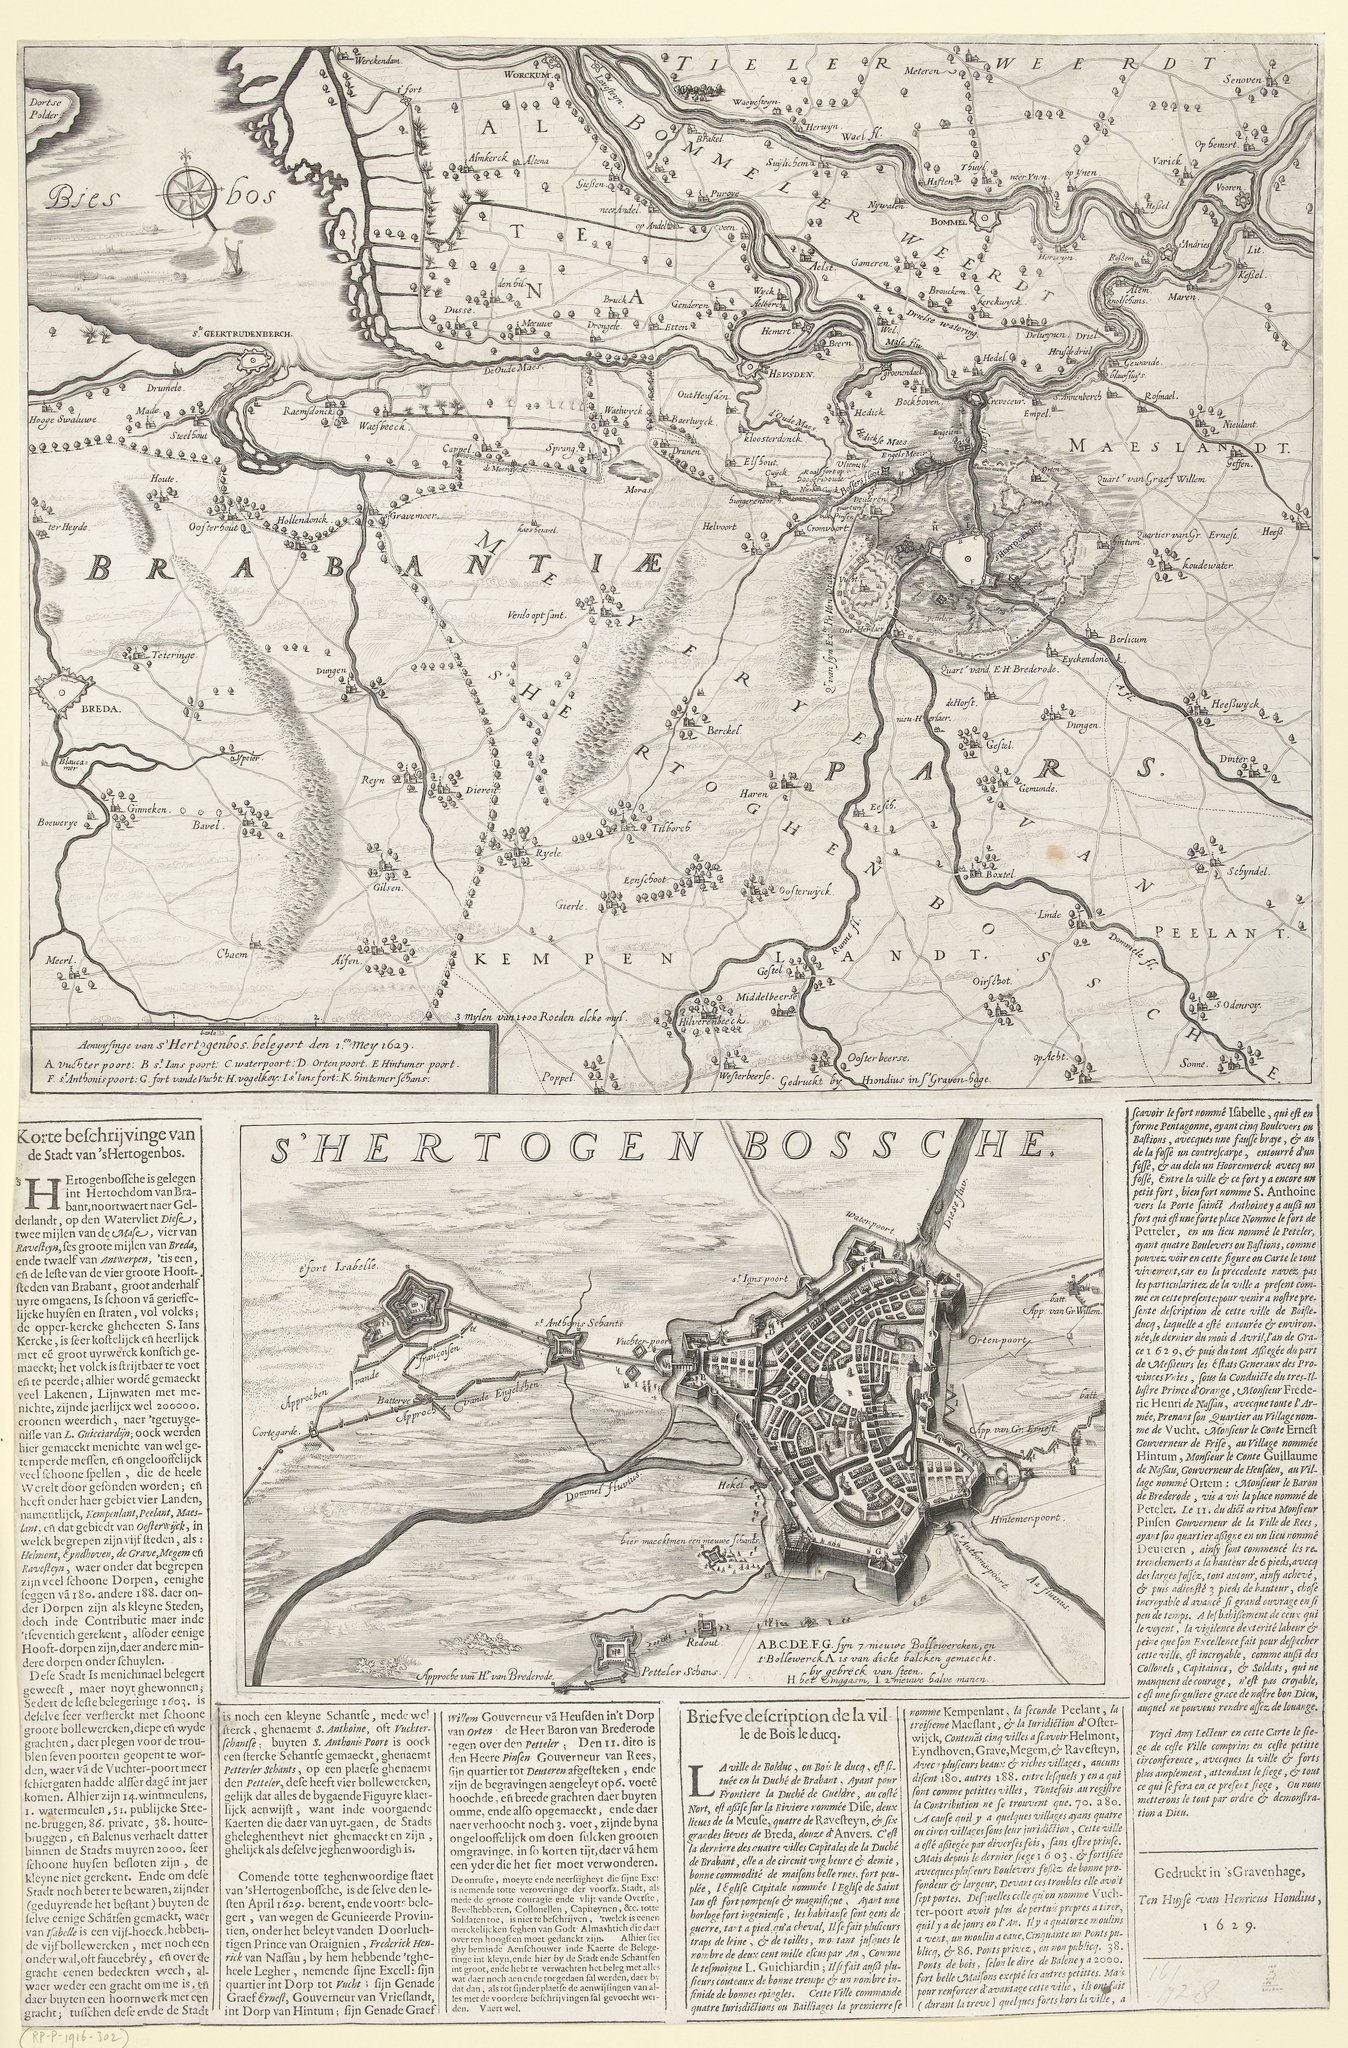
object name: print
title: Kaart van het beleg van Den Bosch en een plattegrond van de stad, 1629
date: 1629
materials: paper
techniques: engraving, letterpress printing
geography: the hague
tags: delft, the hague, frederick henry (prince of orange), maps of separate countries or regions, siege, position war, maps of cities, den bosch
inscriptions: inscription: ‘Veldslagen no. 728’, collector's mark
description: Blad met twee voorstellingen. Bovenaan een kaart van Den Bosch en omgeving, onderaan vastgeplakt een plattegrond van de stad, tijdens het beleg door het Staatse leger onder Frederik Hendrik, van 1 mei tot 17 september 1629. De bovenste kaart heeft een cartouche met de legenda A-K. De onderste kaart heeft links en onderaan 3 kolommen tekst in het Nederlands en onderaan en rechts 3 kolommen tekst in het Frans.